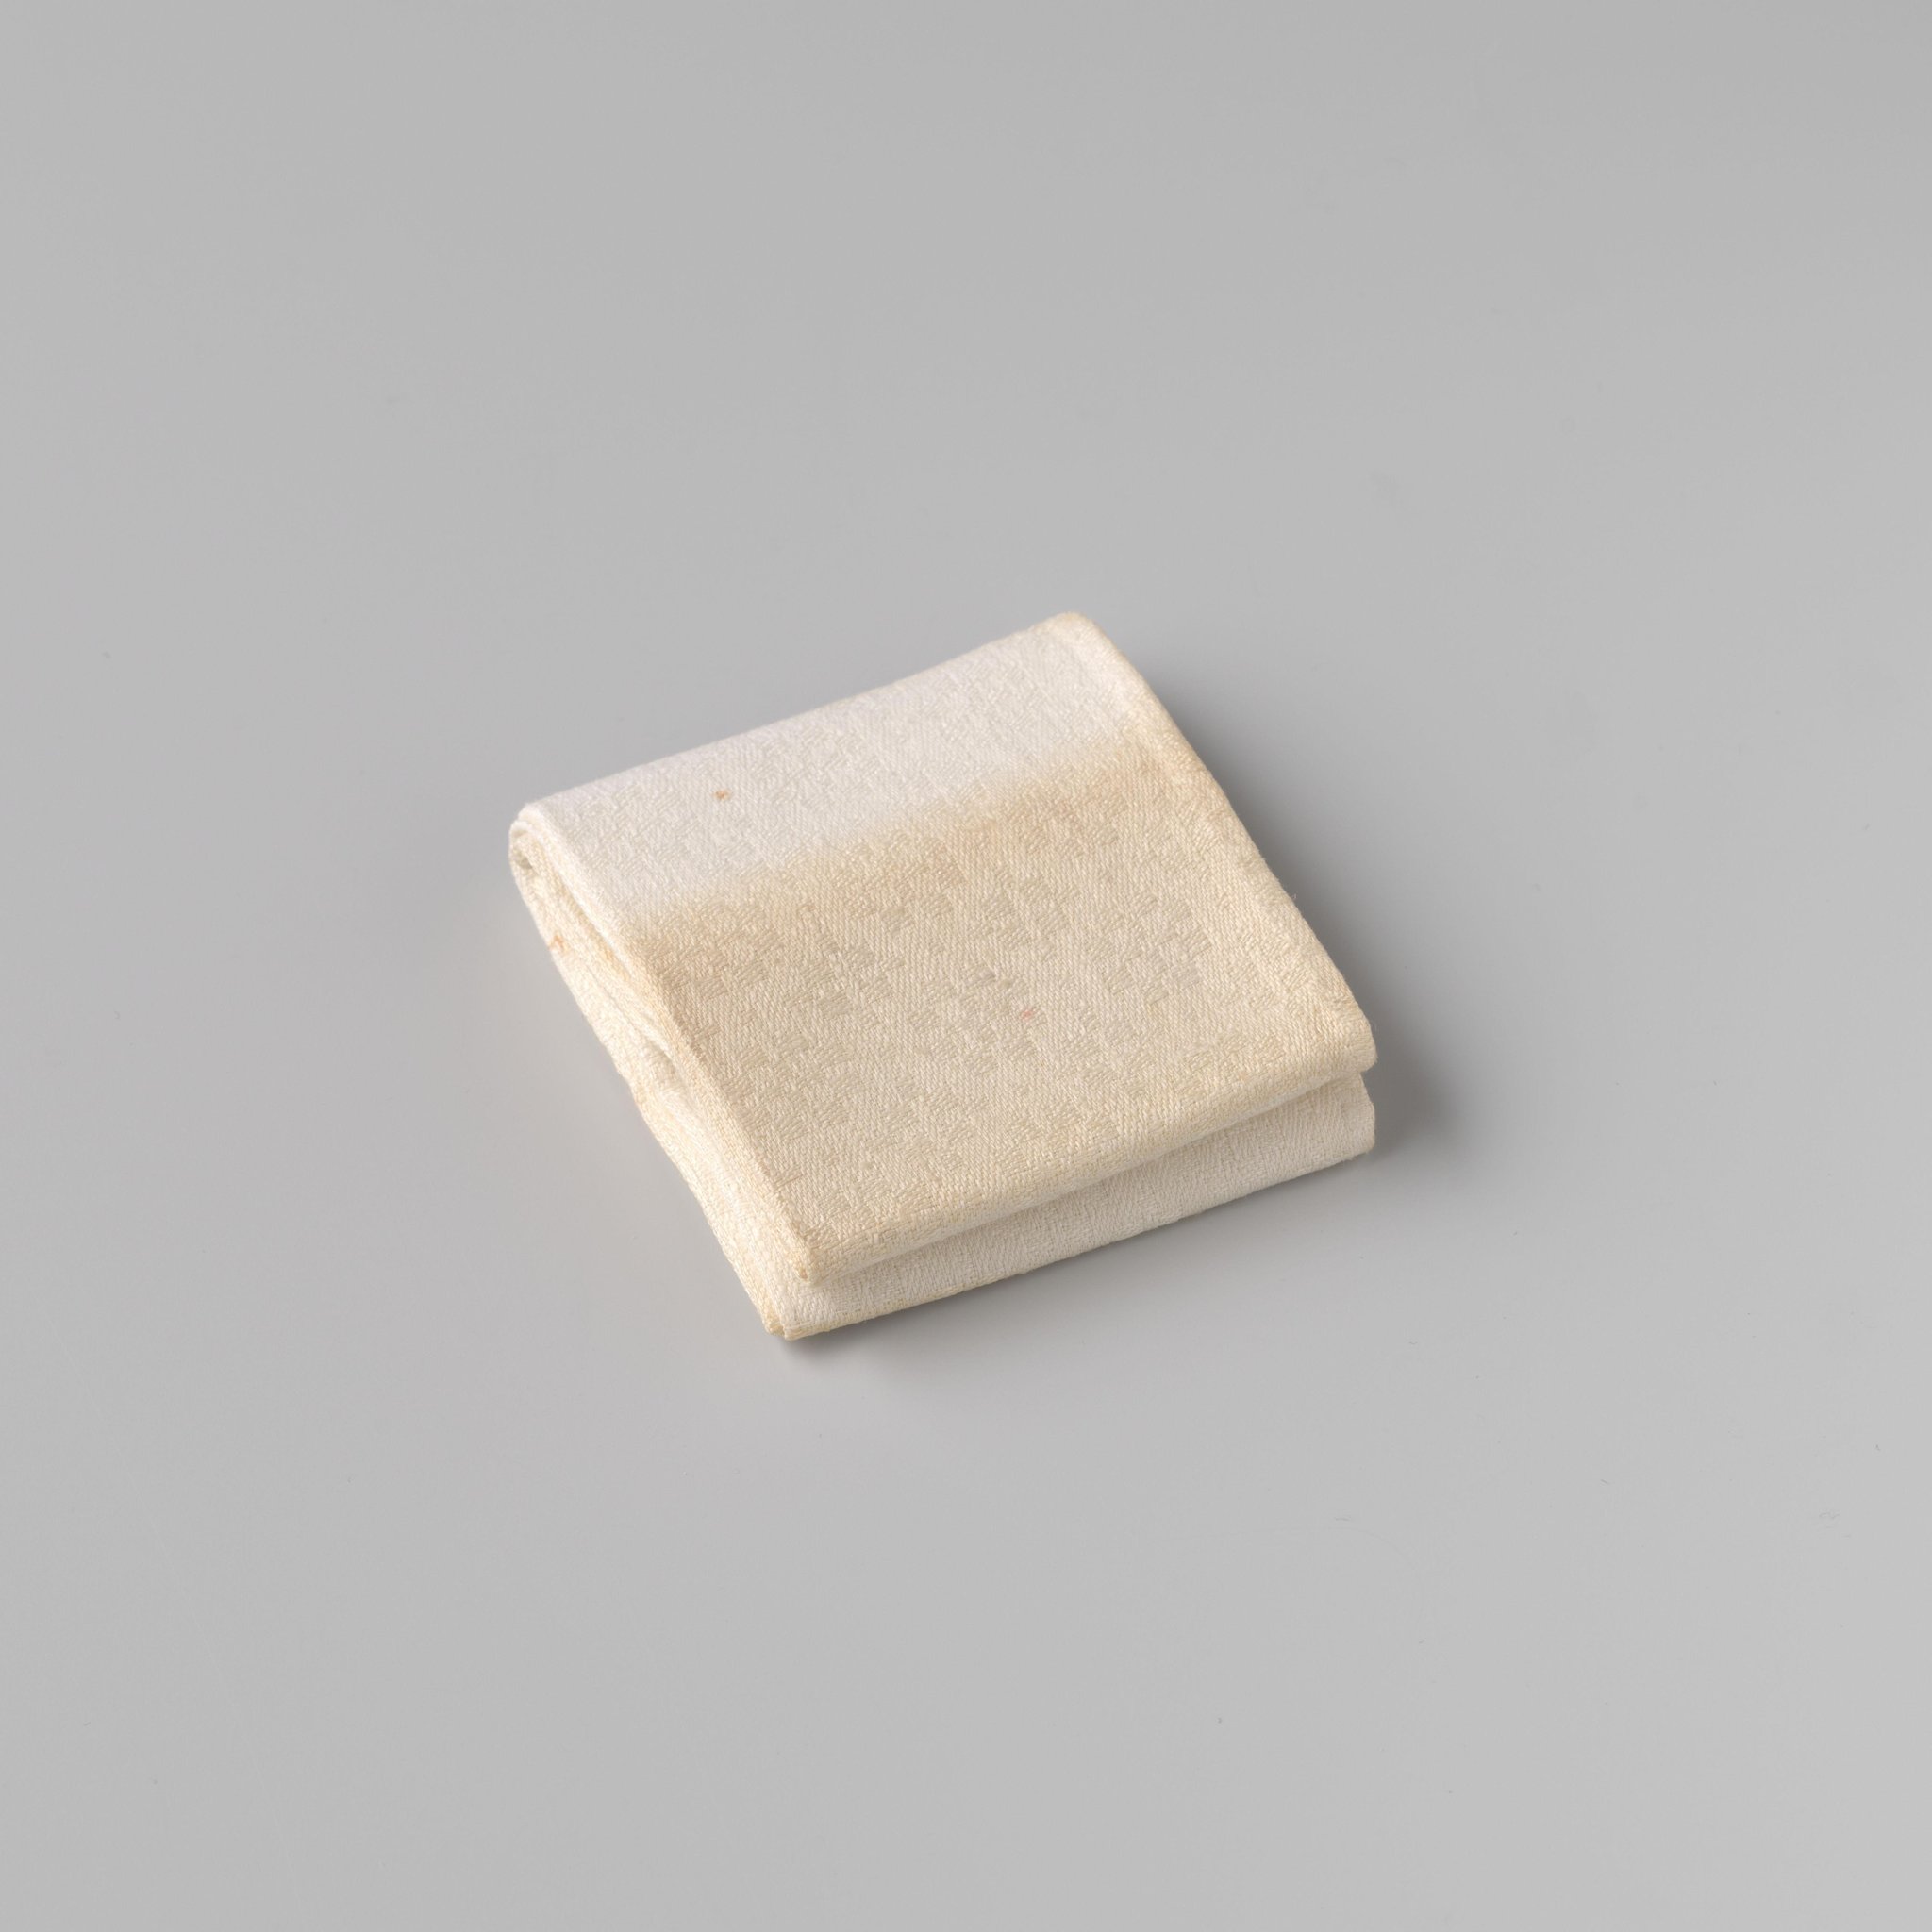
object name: miniature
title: Linnen tafellaken, damastweefsel met pellenpatroon (motief II), aan vier zijden omzoomd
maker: Anonymous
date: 1690-1710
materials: linen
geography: amsterdam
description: Eén van vijf linnen tafellakens, damastweefsel met pellenpatroon (motief II), aan vier zijden omzoomd, laken (BK-NM-1010-75-C) met één zelfkant.